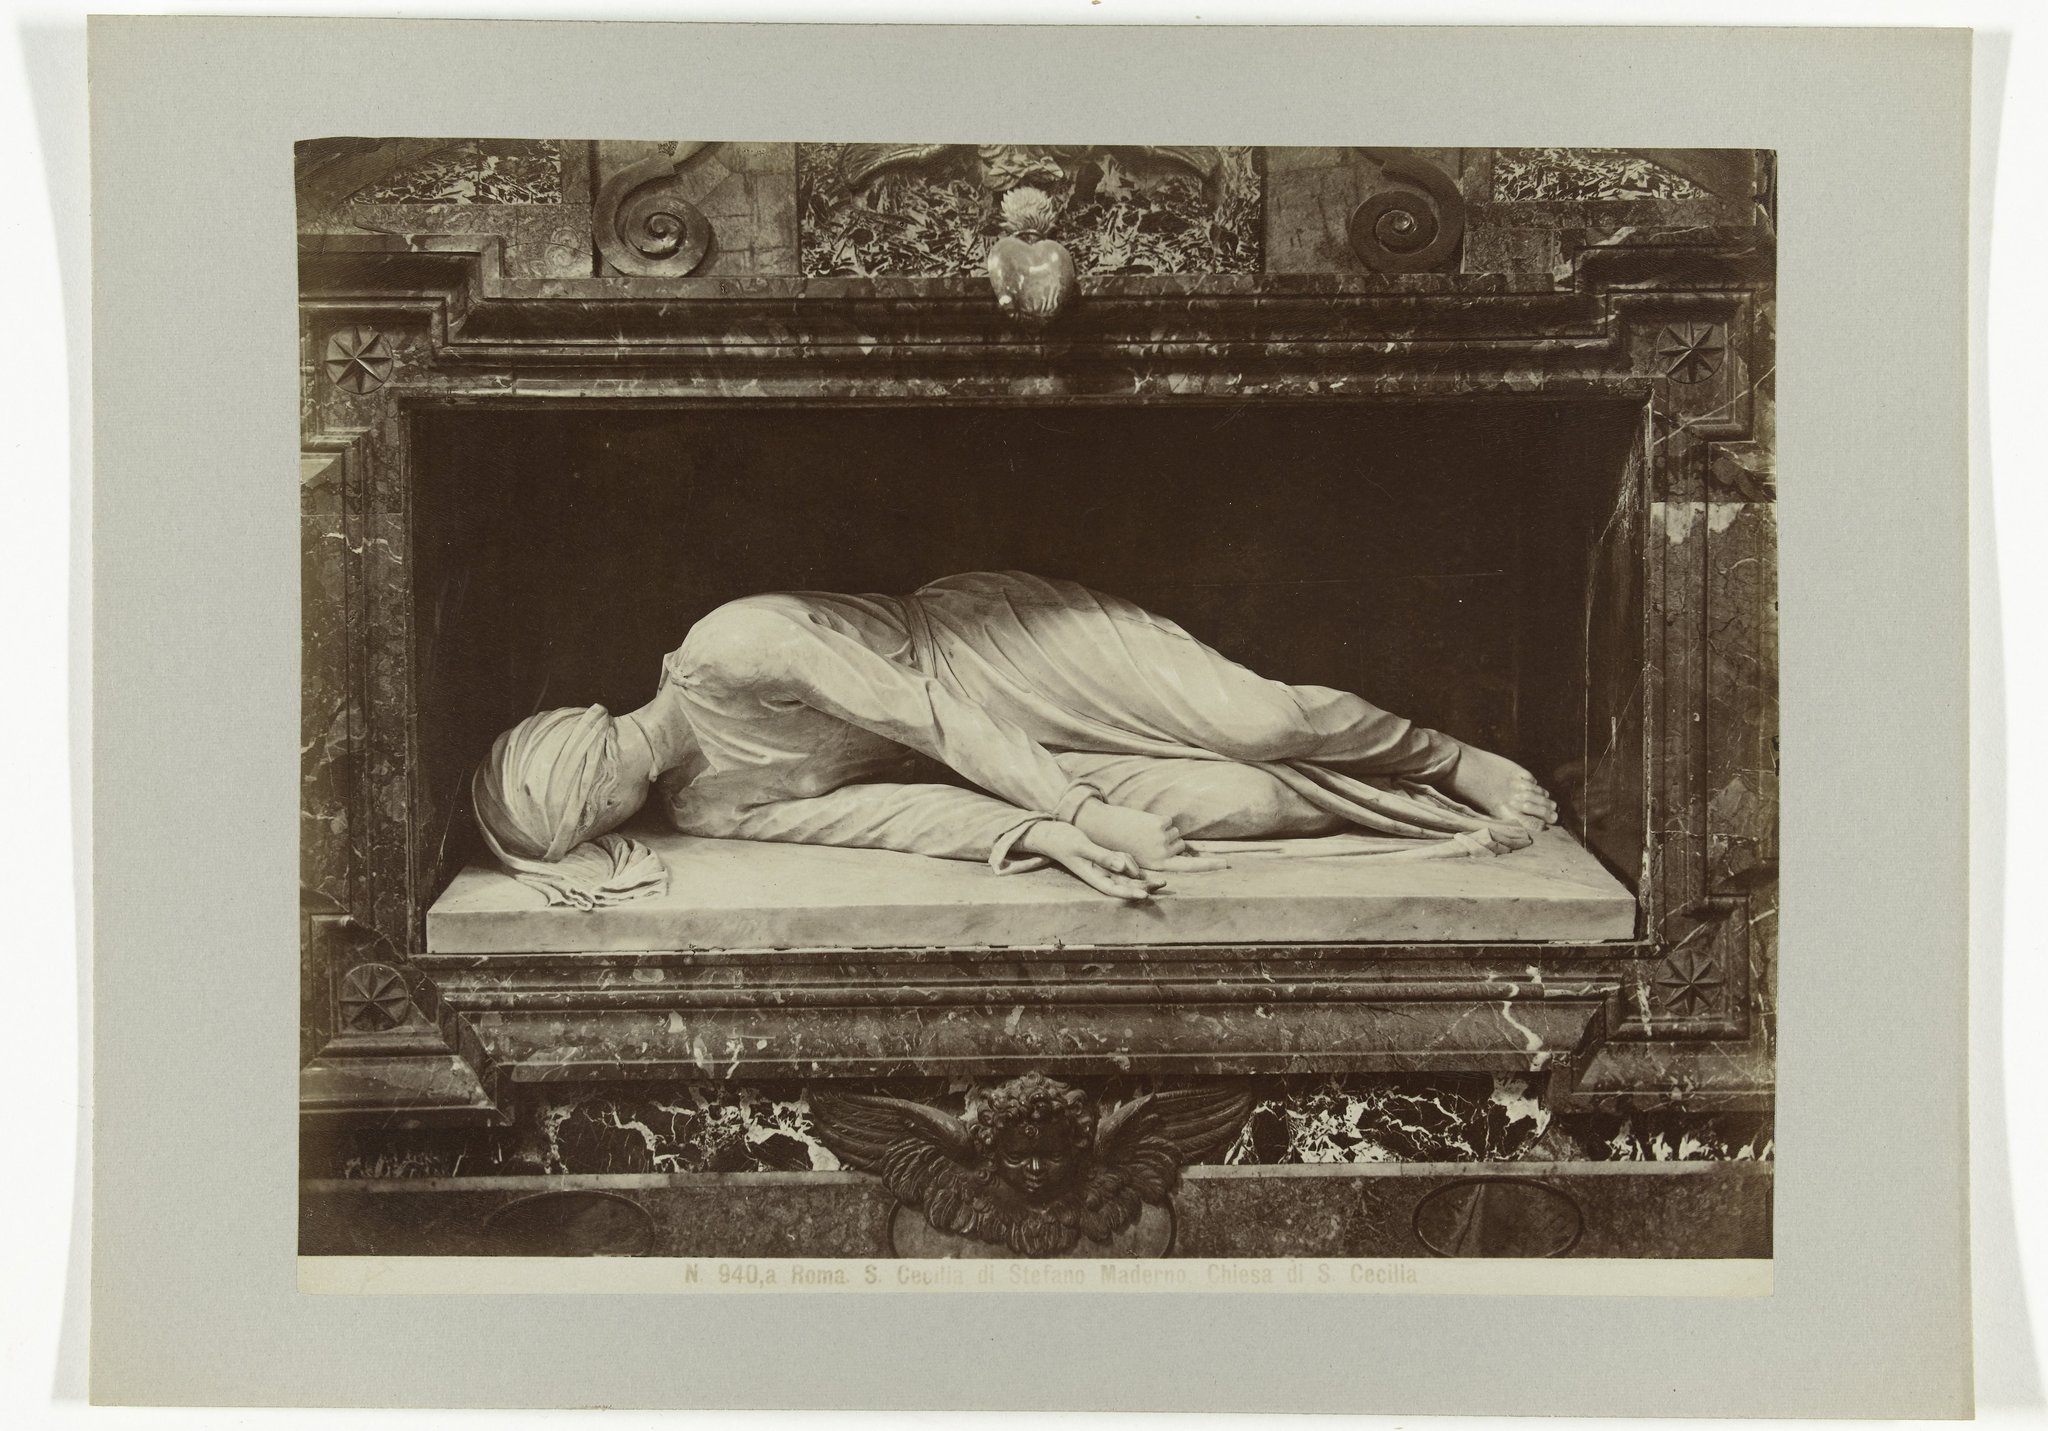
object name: photograph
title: N. 940,a Roma. S. Cecilia di Stefano Maderno Chiesa di S. Cecilia.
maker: Anonymous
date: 1880-1904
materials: cardboard, paper, photographic support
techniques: albumen print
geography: rome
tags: rome